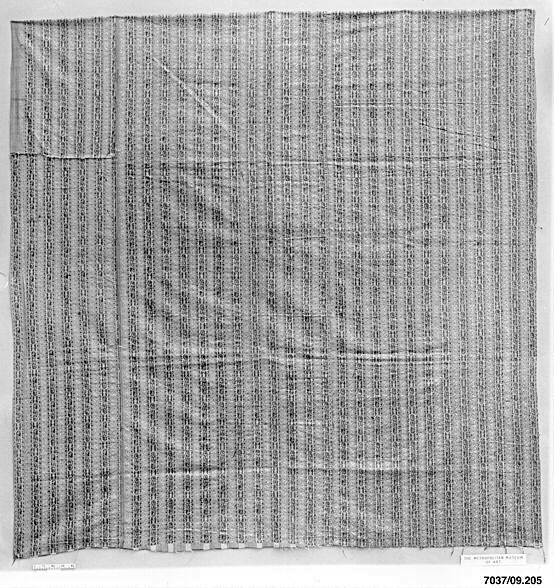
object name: brocade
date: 1801-1833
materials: linen, metal thread, silk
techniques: damask, weave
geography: india